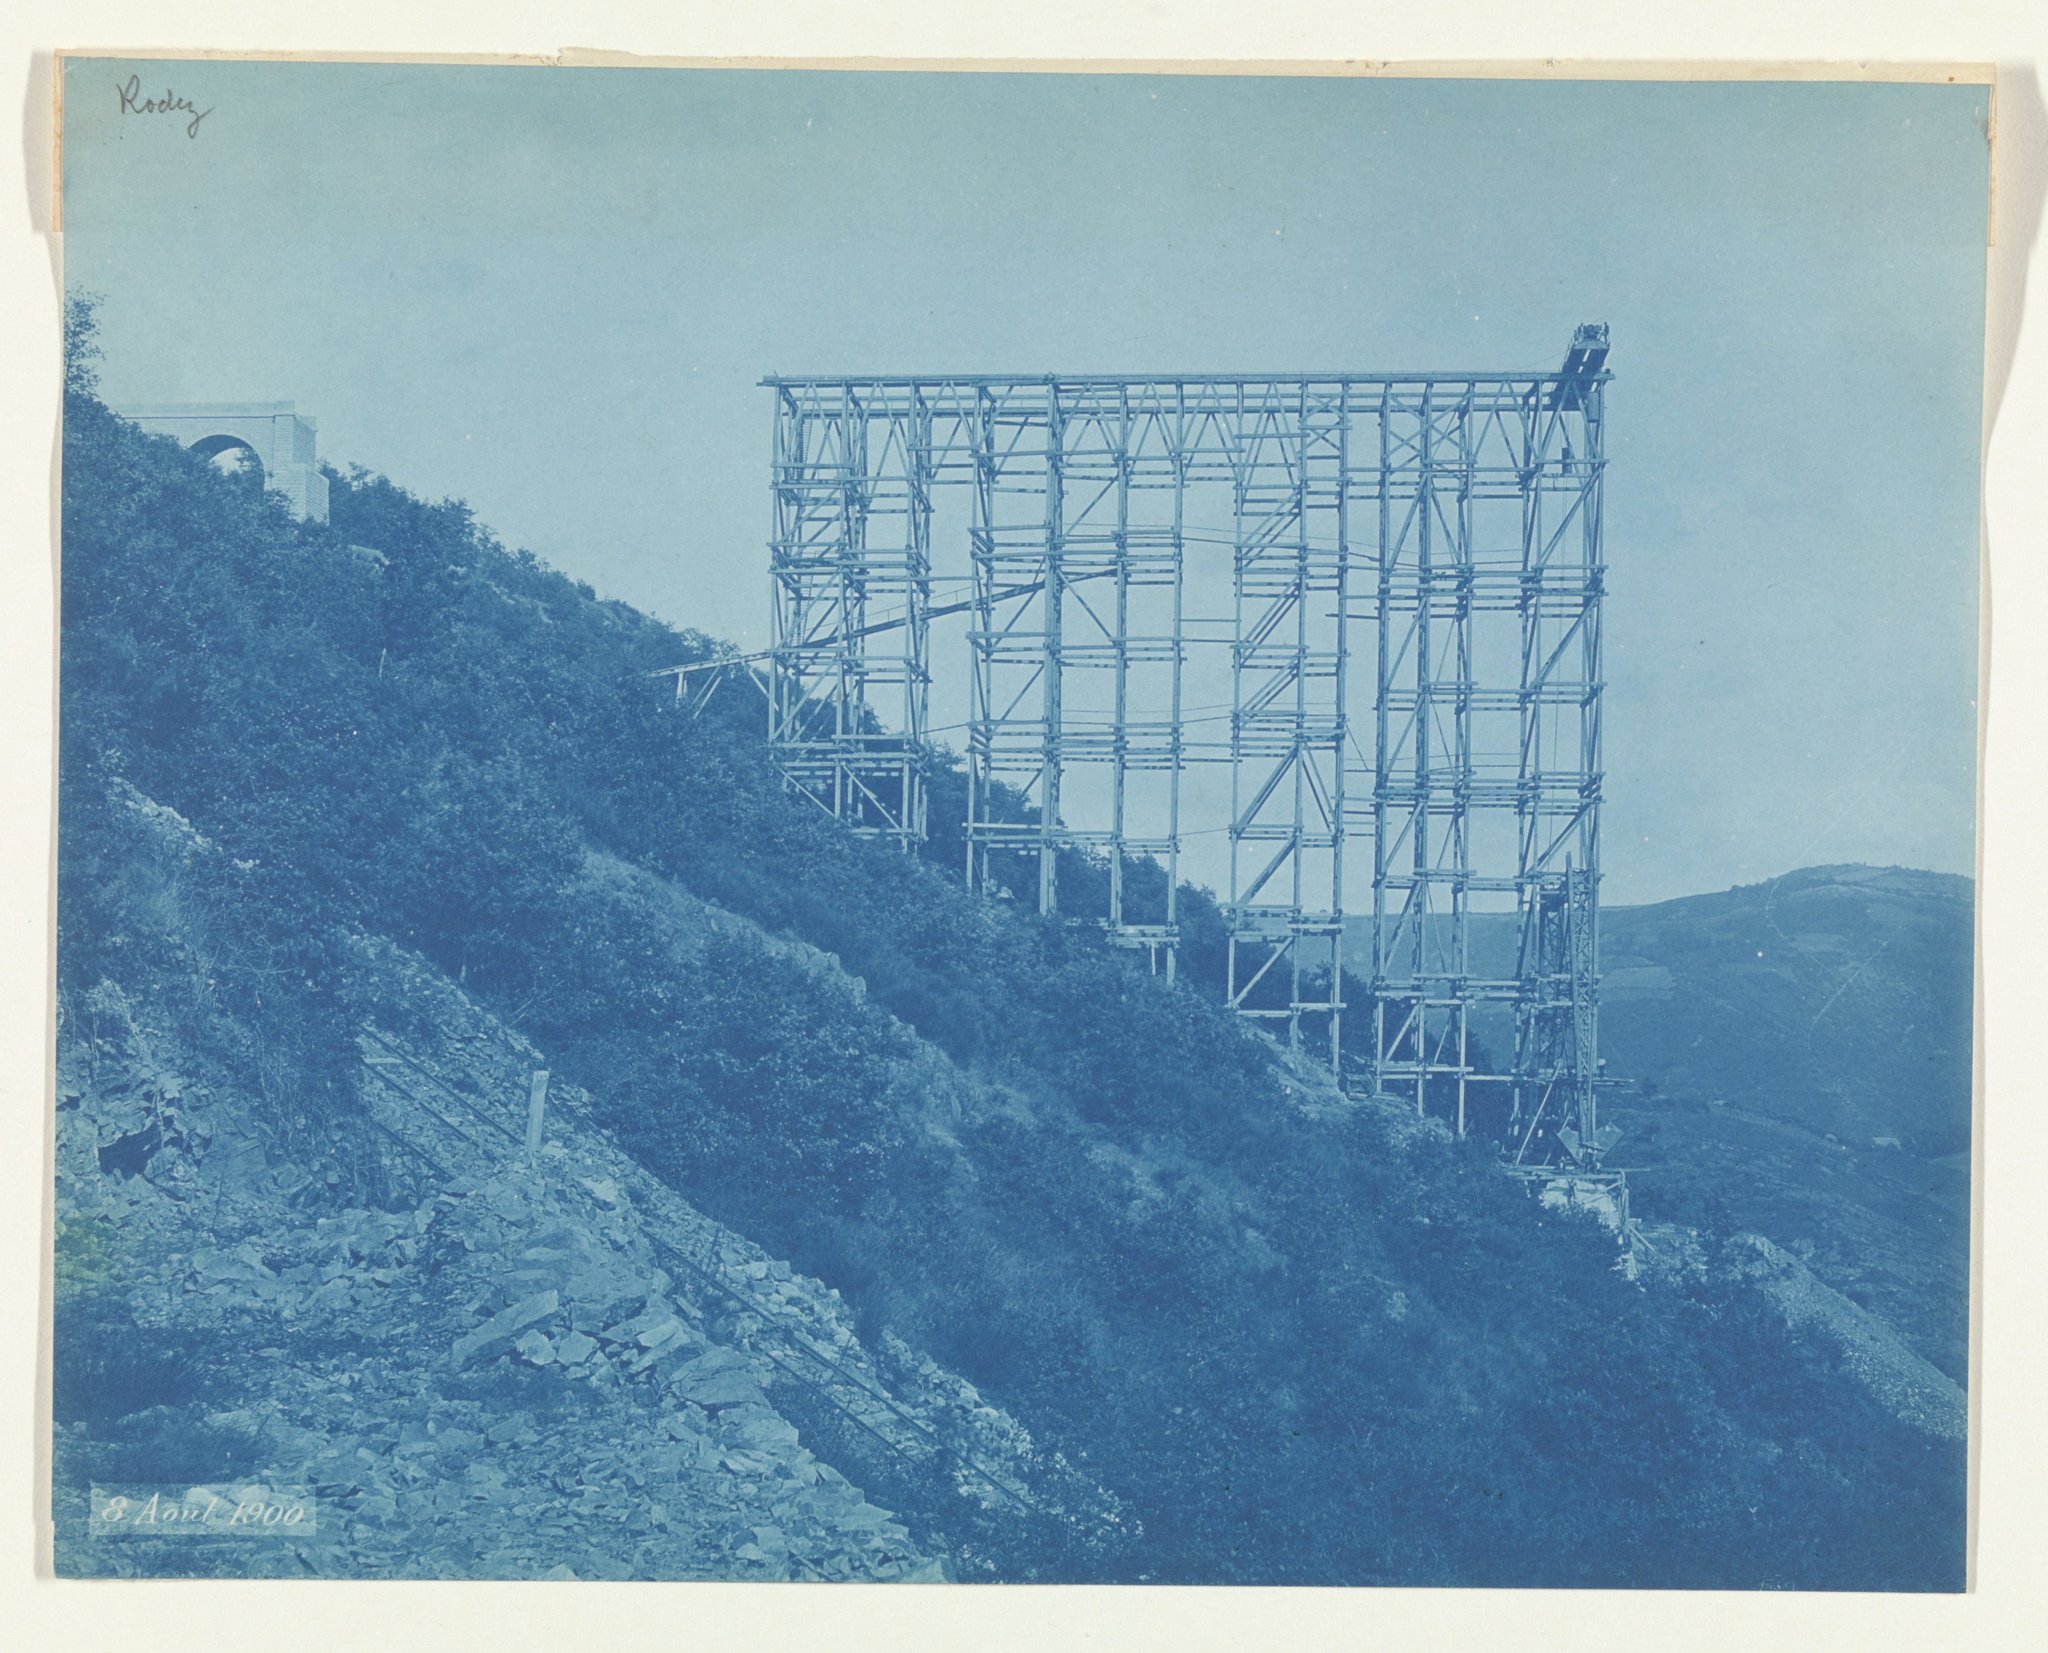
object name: photograph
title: Aanleg van het Viaur Viaduct in Frankrijk door de Societé de Construction des Battignolles, 8 augustus 1900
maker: Anonymous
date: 1900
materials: photographic support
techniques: cyanotype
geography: france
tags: viaduct, making the overground structures (~ building activities)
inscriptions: inscription: ‘Rodez’